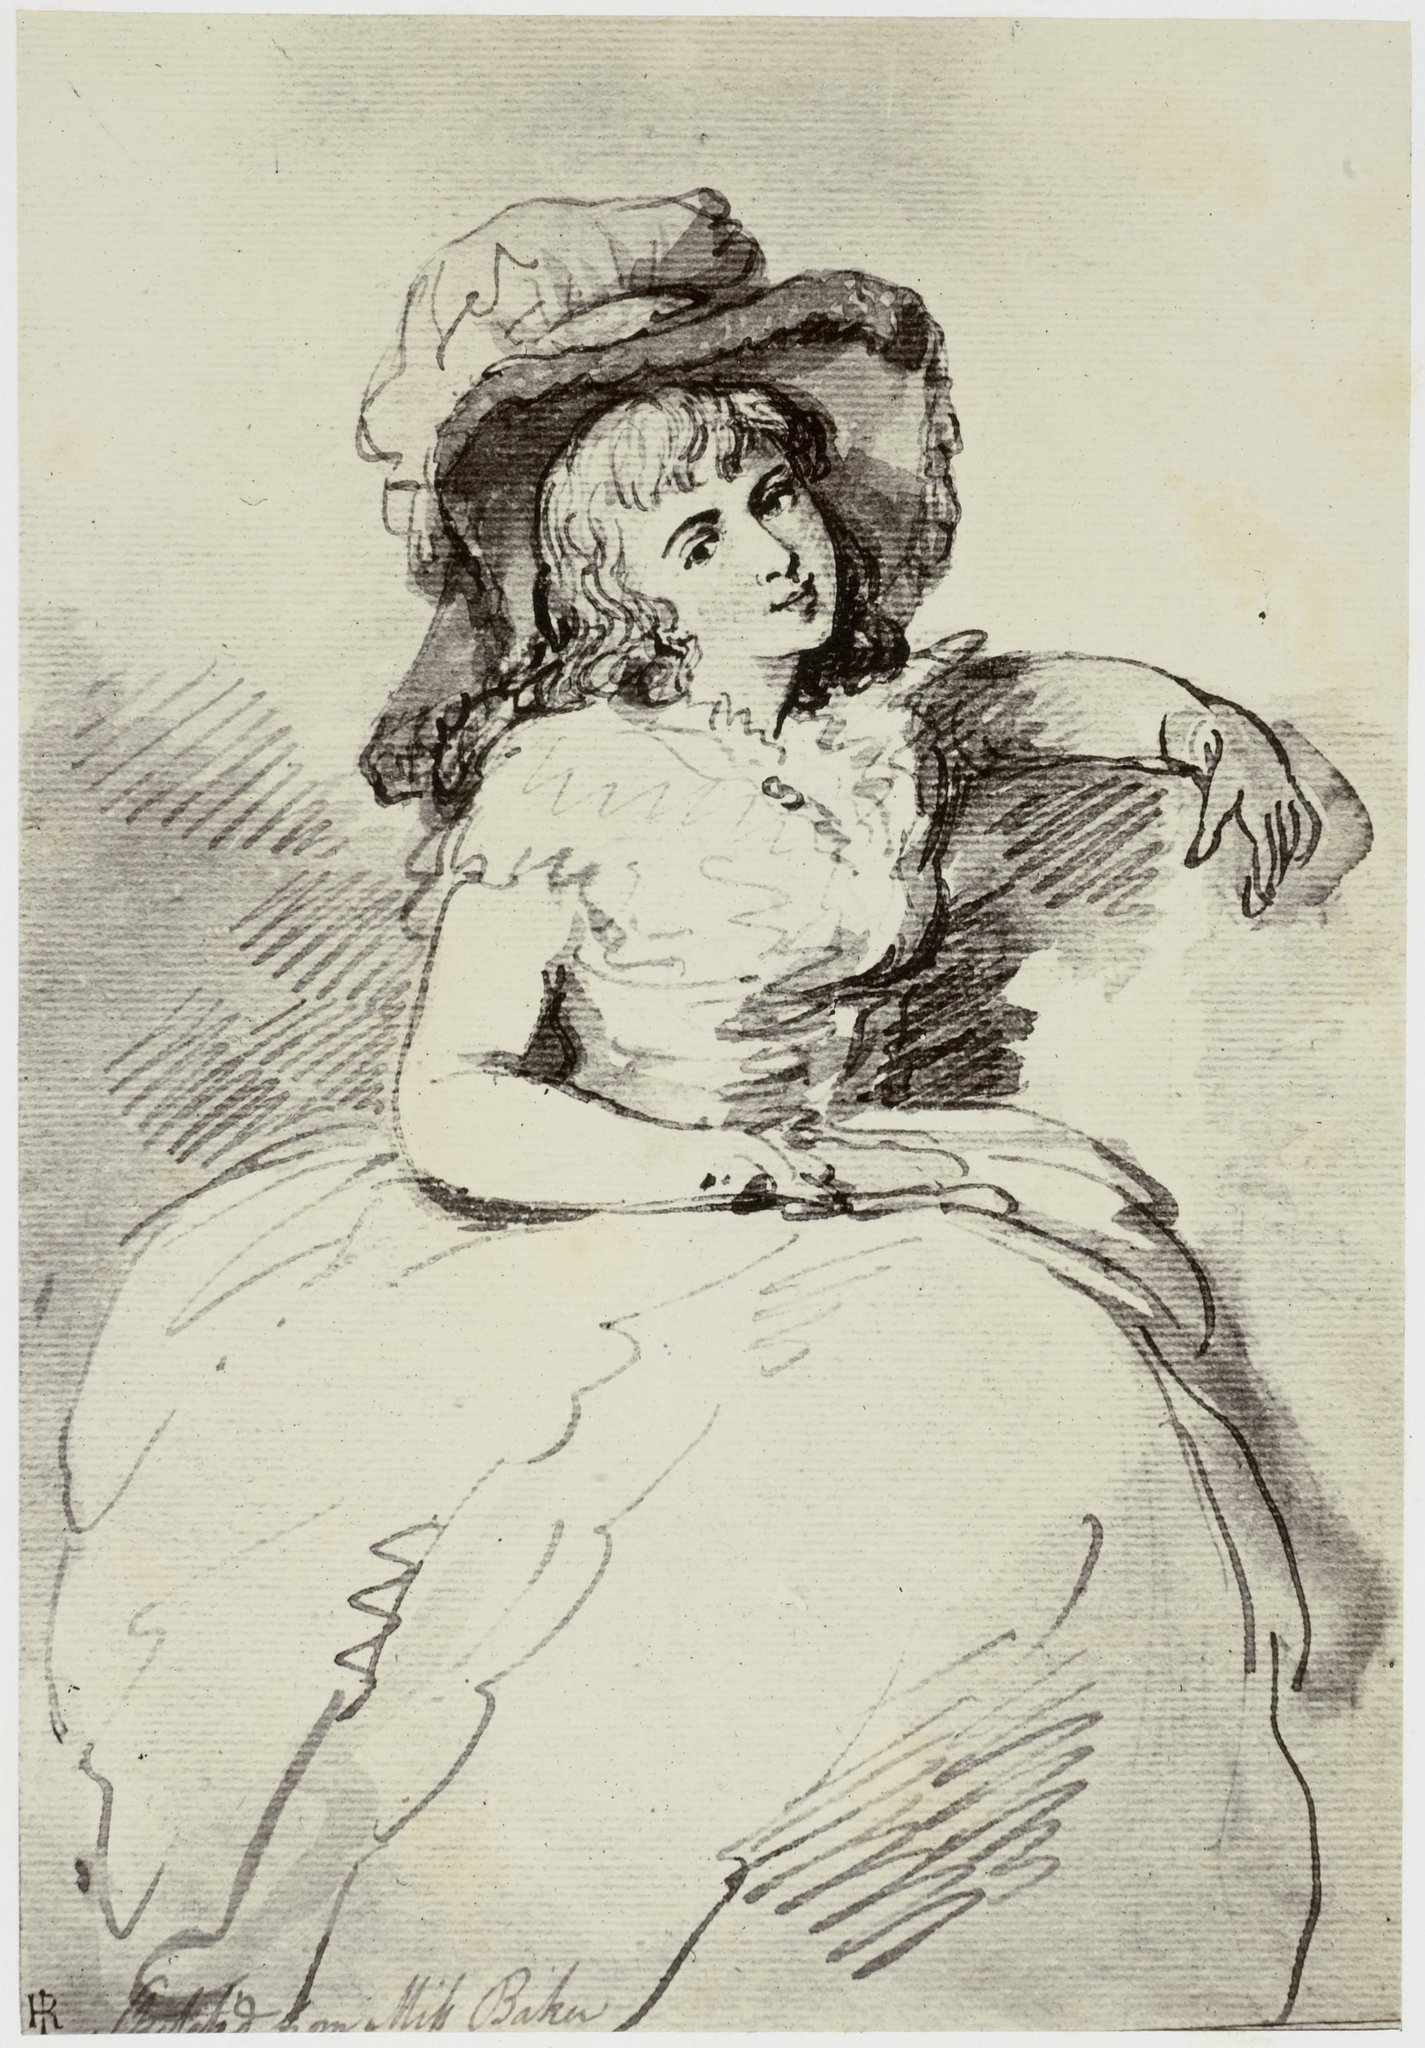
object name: photograph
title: Thomas Rowlandson, Miss Baker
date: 1855-1858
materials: cardboard, paper, photographic support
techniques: albumen print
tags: drawing, sketch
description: Fotoreproductie van tekening in 'The Reveley Collection of Drawings at Brynygwin', afb. 53.